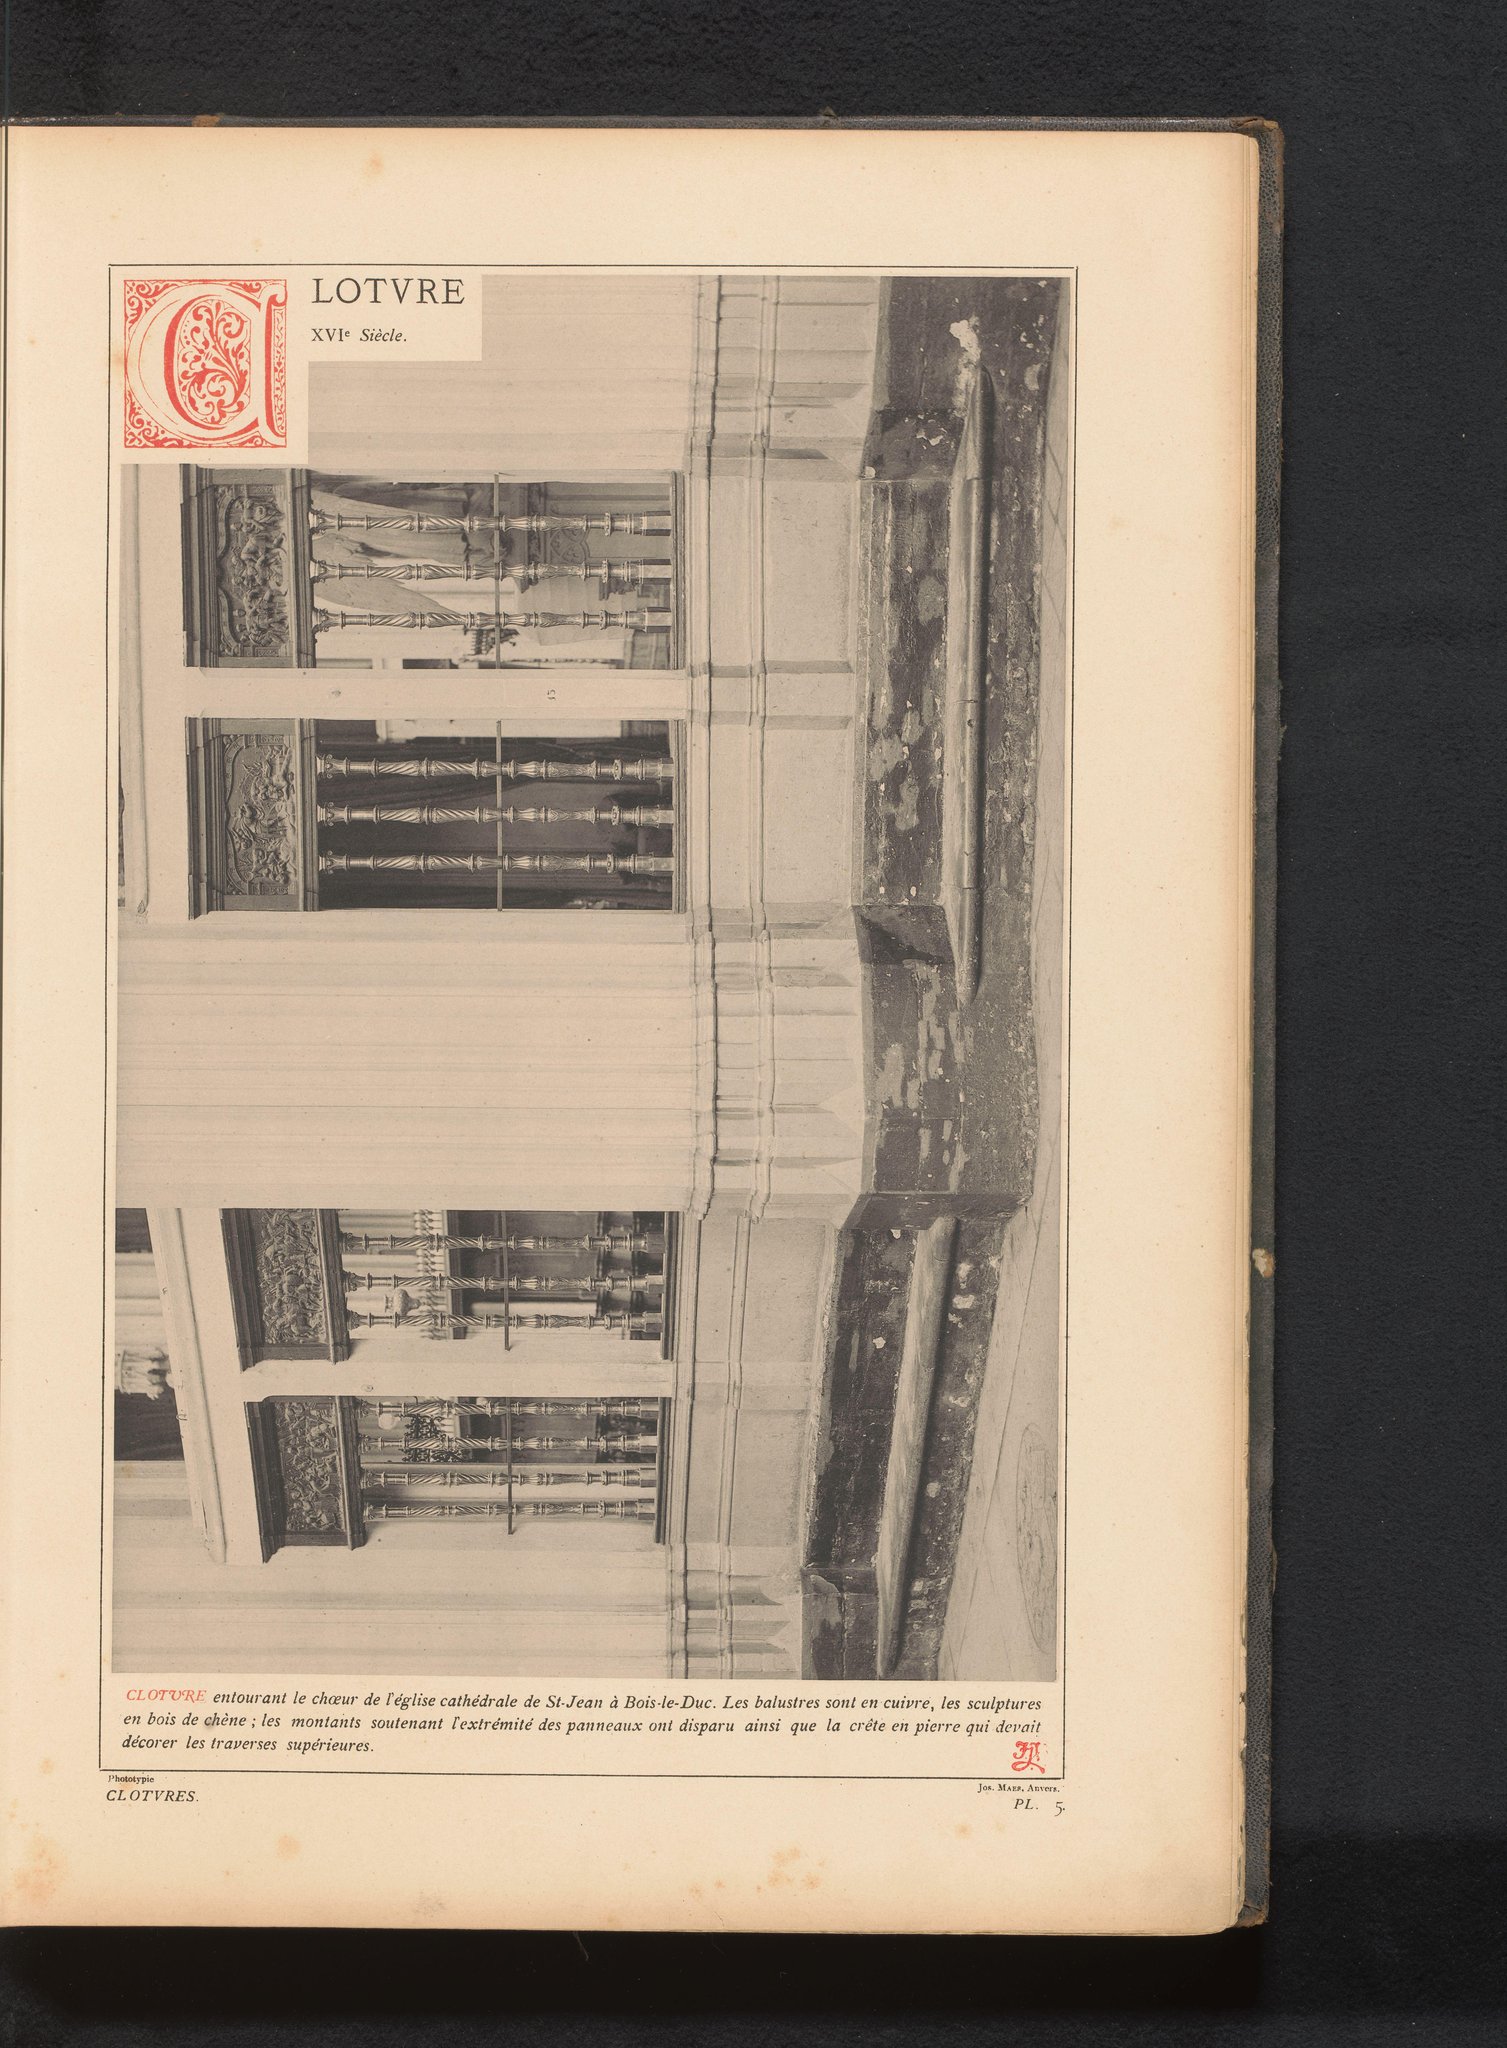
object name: page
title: Cloture, XVIe Siècle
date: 1881-1889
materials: paper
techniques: photograph, photolithography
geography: antwerp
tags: interior of church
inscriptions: inscription: ‘COTURES. PL. 5.’, monogram: ‘JJvY’, inscription: ‘CLOTURE entourant le (...)’